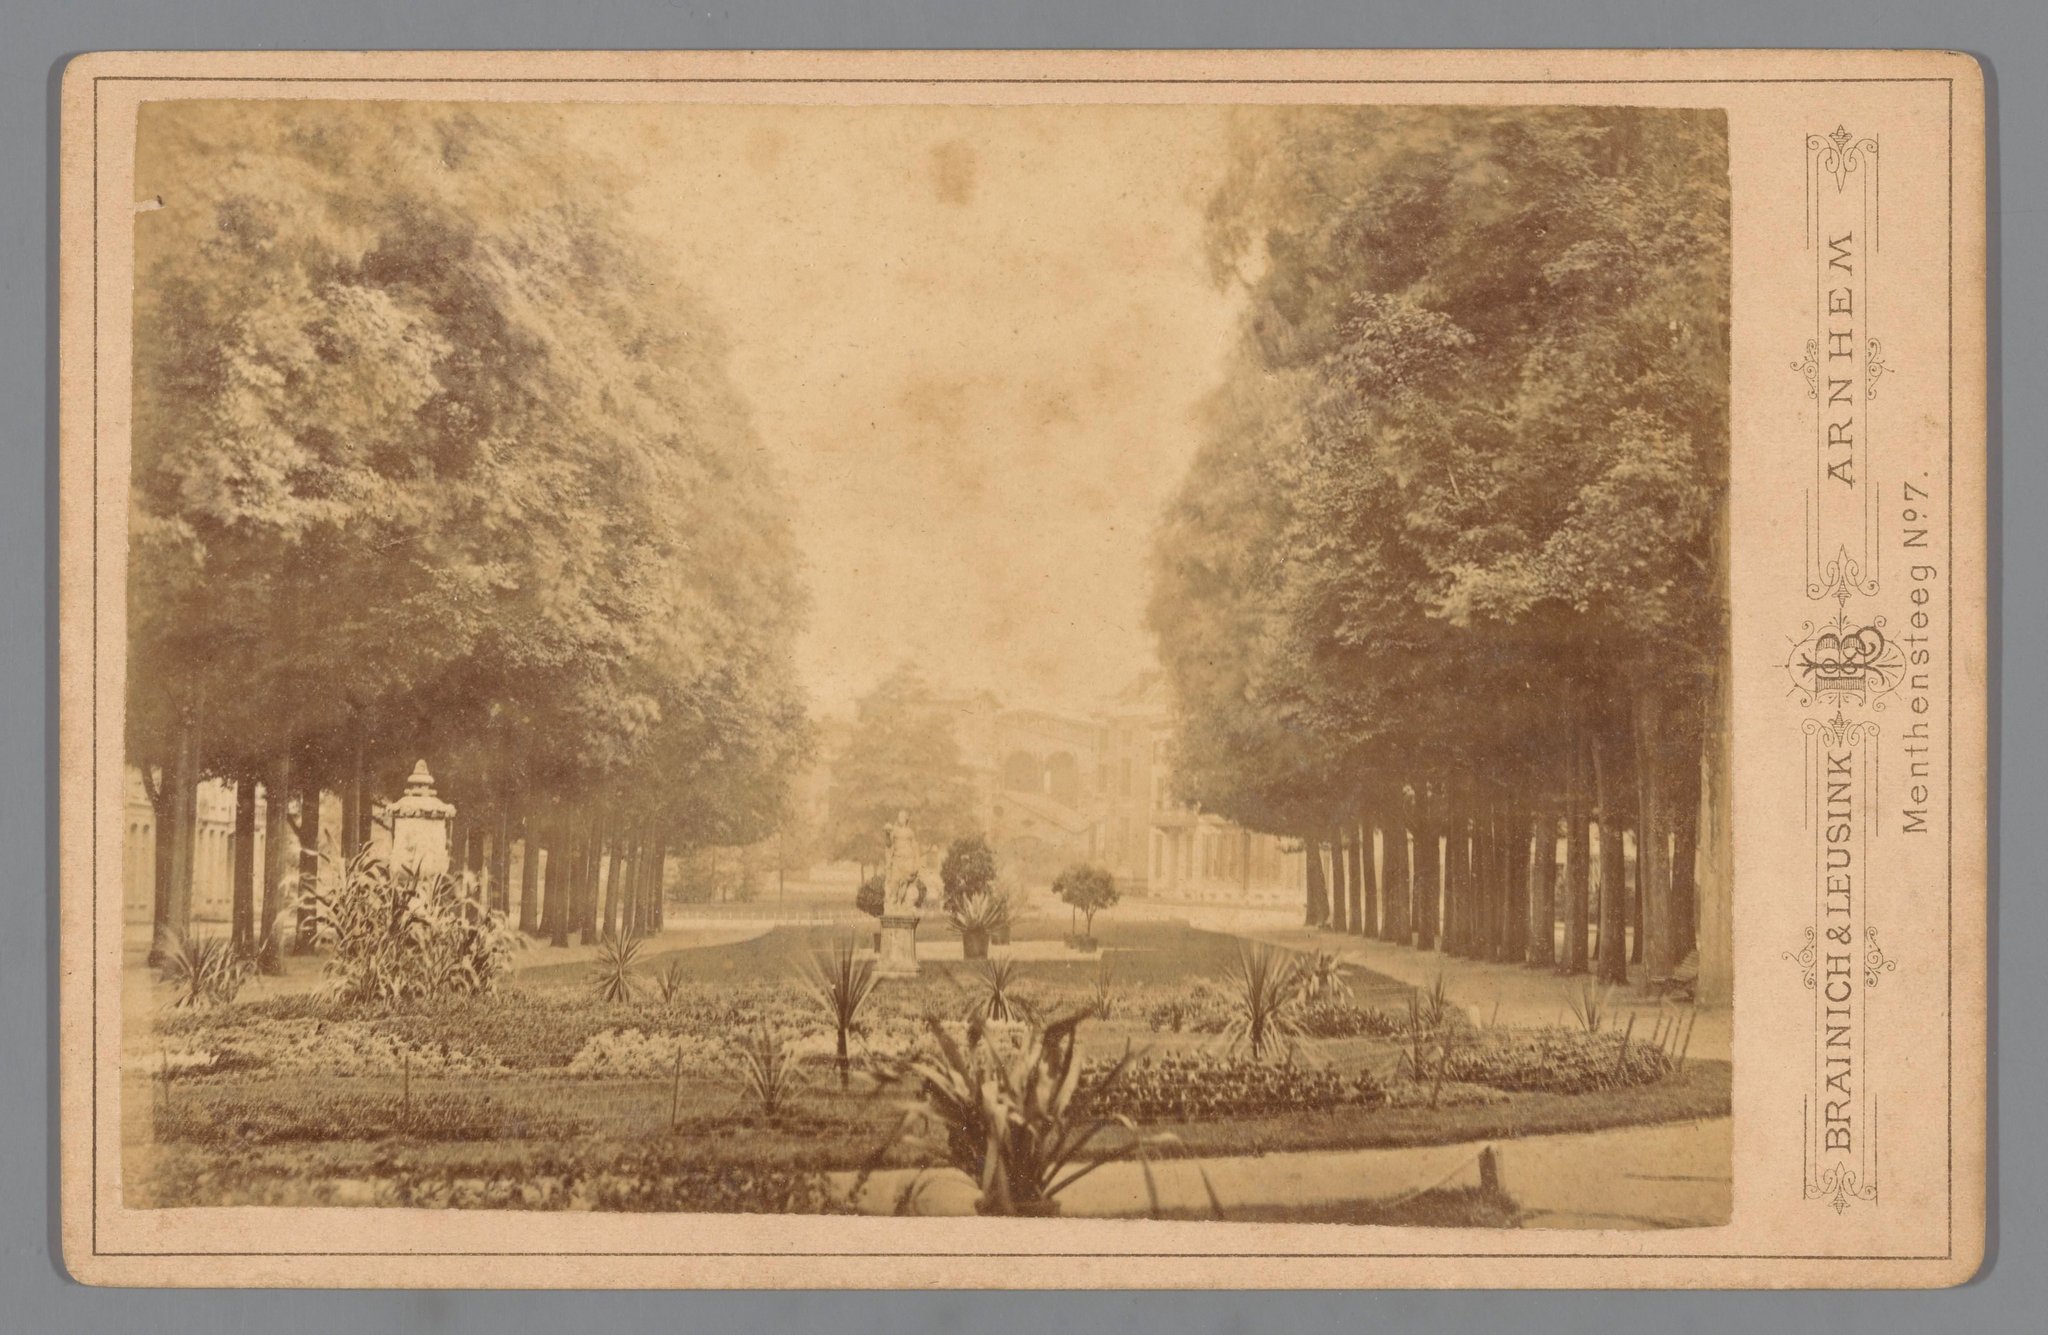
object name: photograph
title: Gezicht op de Janssingel in Arnhem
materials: cardboard, photographic support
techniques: albumen print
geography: arnhem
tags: park, street, arnhem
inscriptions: address: ‘Menthensteeg No. 7.’, annotation: ‘Ter herinnering lieve Cor aan/ je hartelijk liefh. vriendin/ Nelly/ 16 Juni 1882.’, annotation: ‘Janssingel, gezicht op het telegraafbureau’